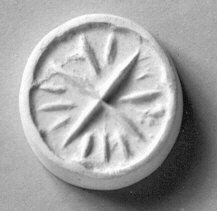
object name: stamp seal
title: Hemispheroid seal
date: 5000-3001 BCE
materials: mineral, stone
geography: northern syria, mesopotamia or western iran